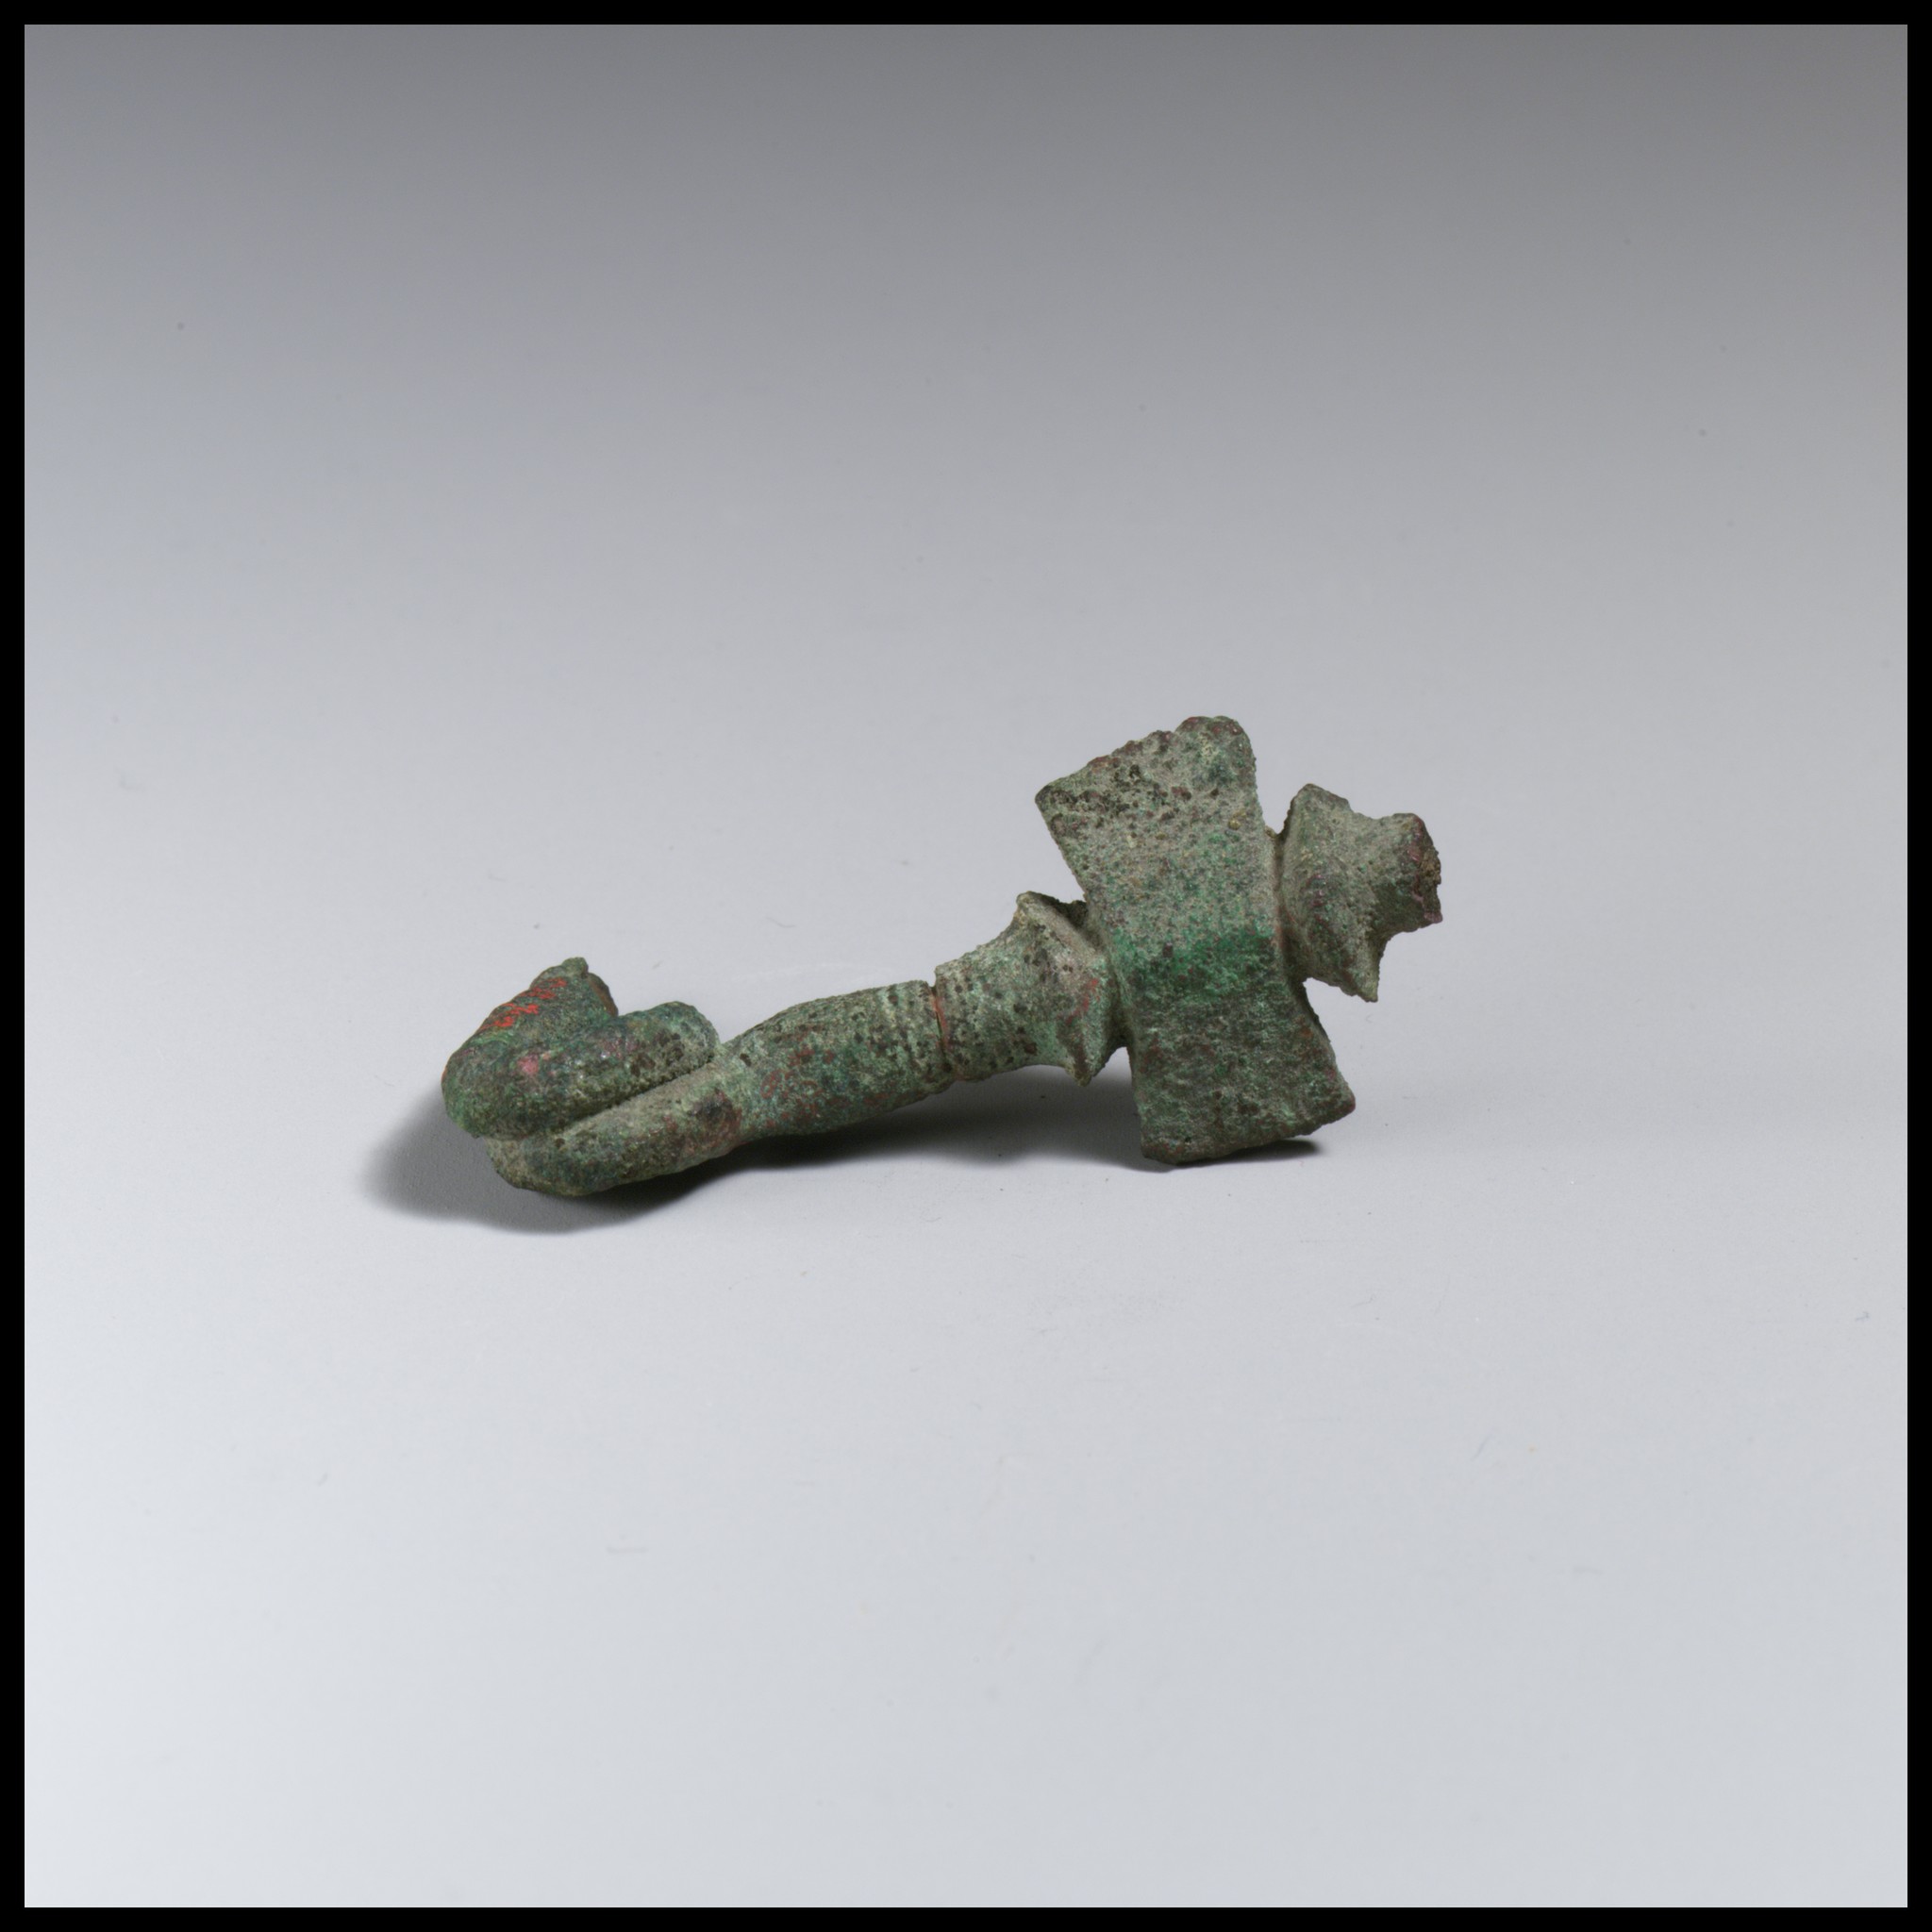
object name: fibula, fragment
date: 7000 BCE-330 CE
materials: bronze